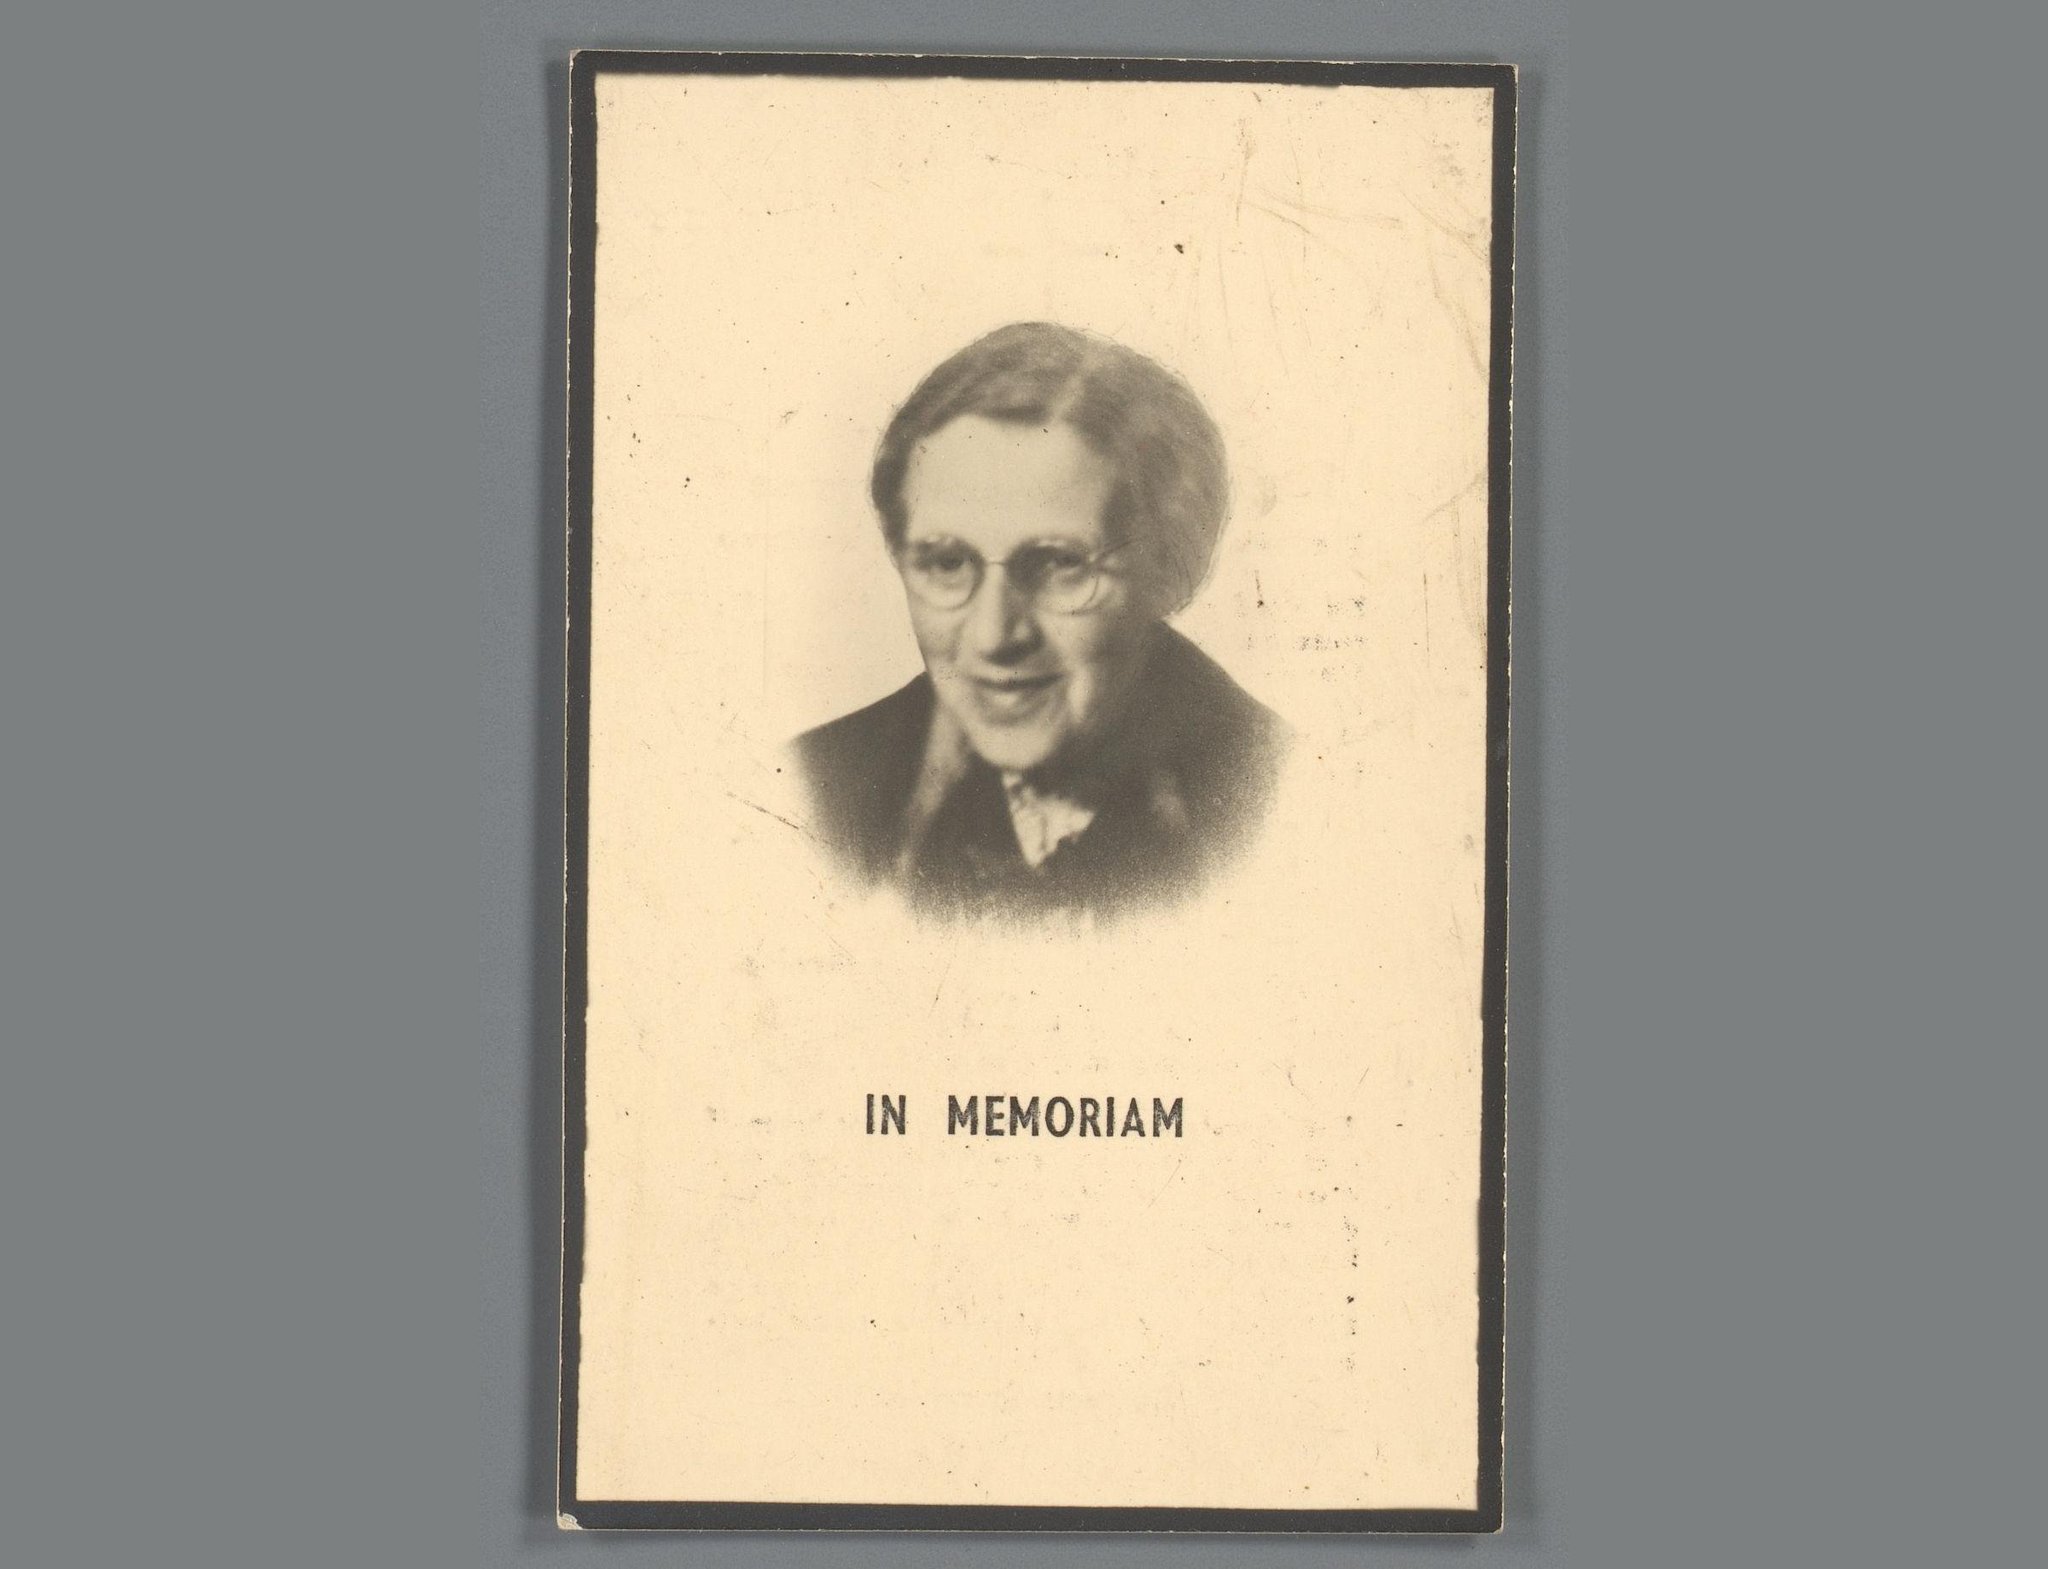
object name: prayer card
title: Portret van Elisabeth Petronella Reyerse op bidprent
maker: Anonymous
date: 1956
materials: paper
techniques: gelatin silver print, letterpress printing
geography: naarden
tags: historical persons, old woman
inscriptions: inscription: ‘Gedenk in Uw gebeden (...) Zij ruste in vrede.’